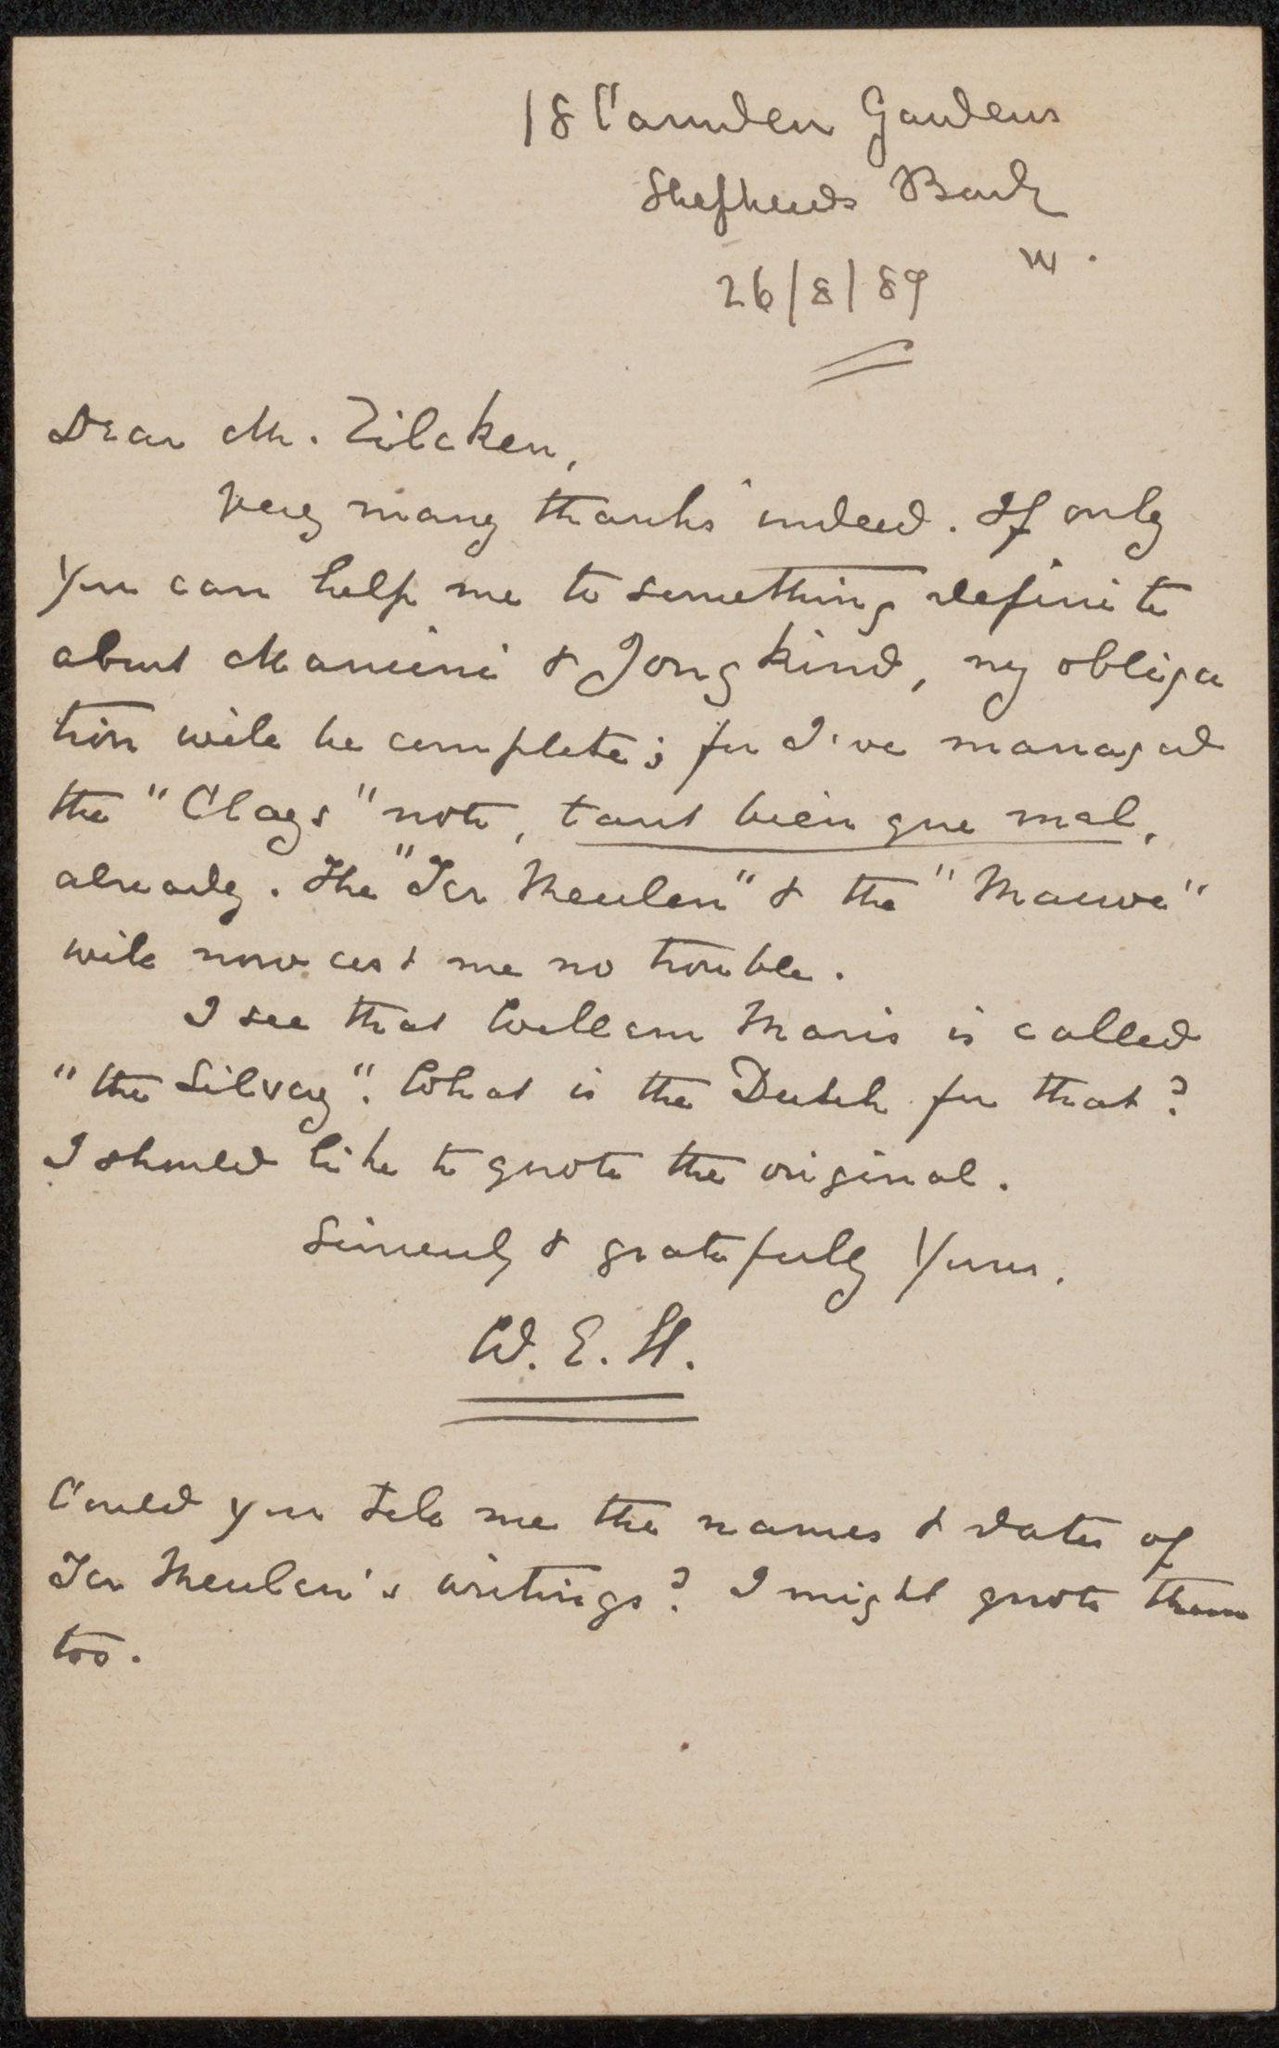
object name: letter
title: Brief aan Philip Zilcken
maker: william ernest henley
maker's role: criticus, dichter, redacteur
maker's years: 1849-1903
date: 1887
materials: ink, paper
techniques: pen, writing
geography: shepherd's bush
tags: bodegraven, the hague, painter, françois pieter ter meulen, print maker, johan barthold jongkind, willem maris, anton mauve, draughtsman, philip zilcken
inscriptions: collector's mark: ‘RPK’